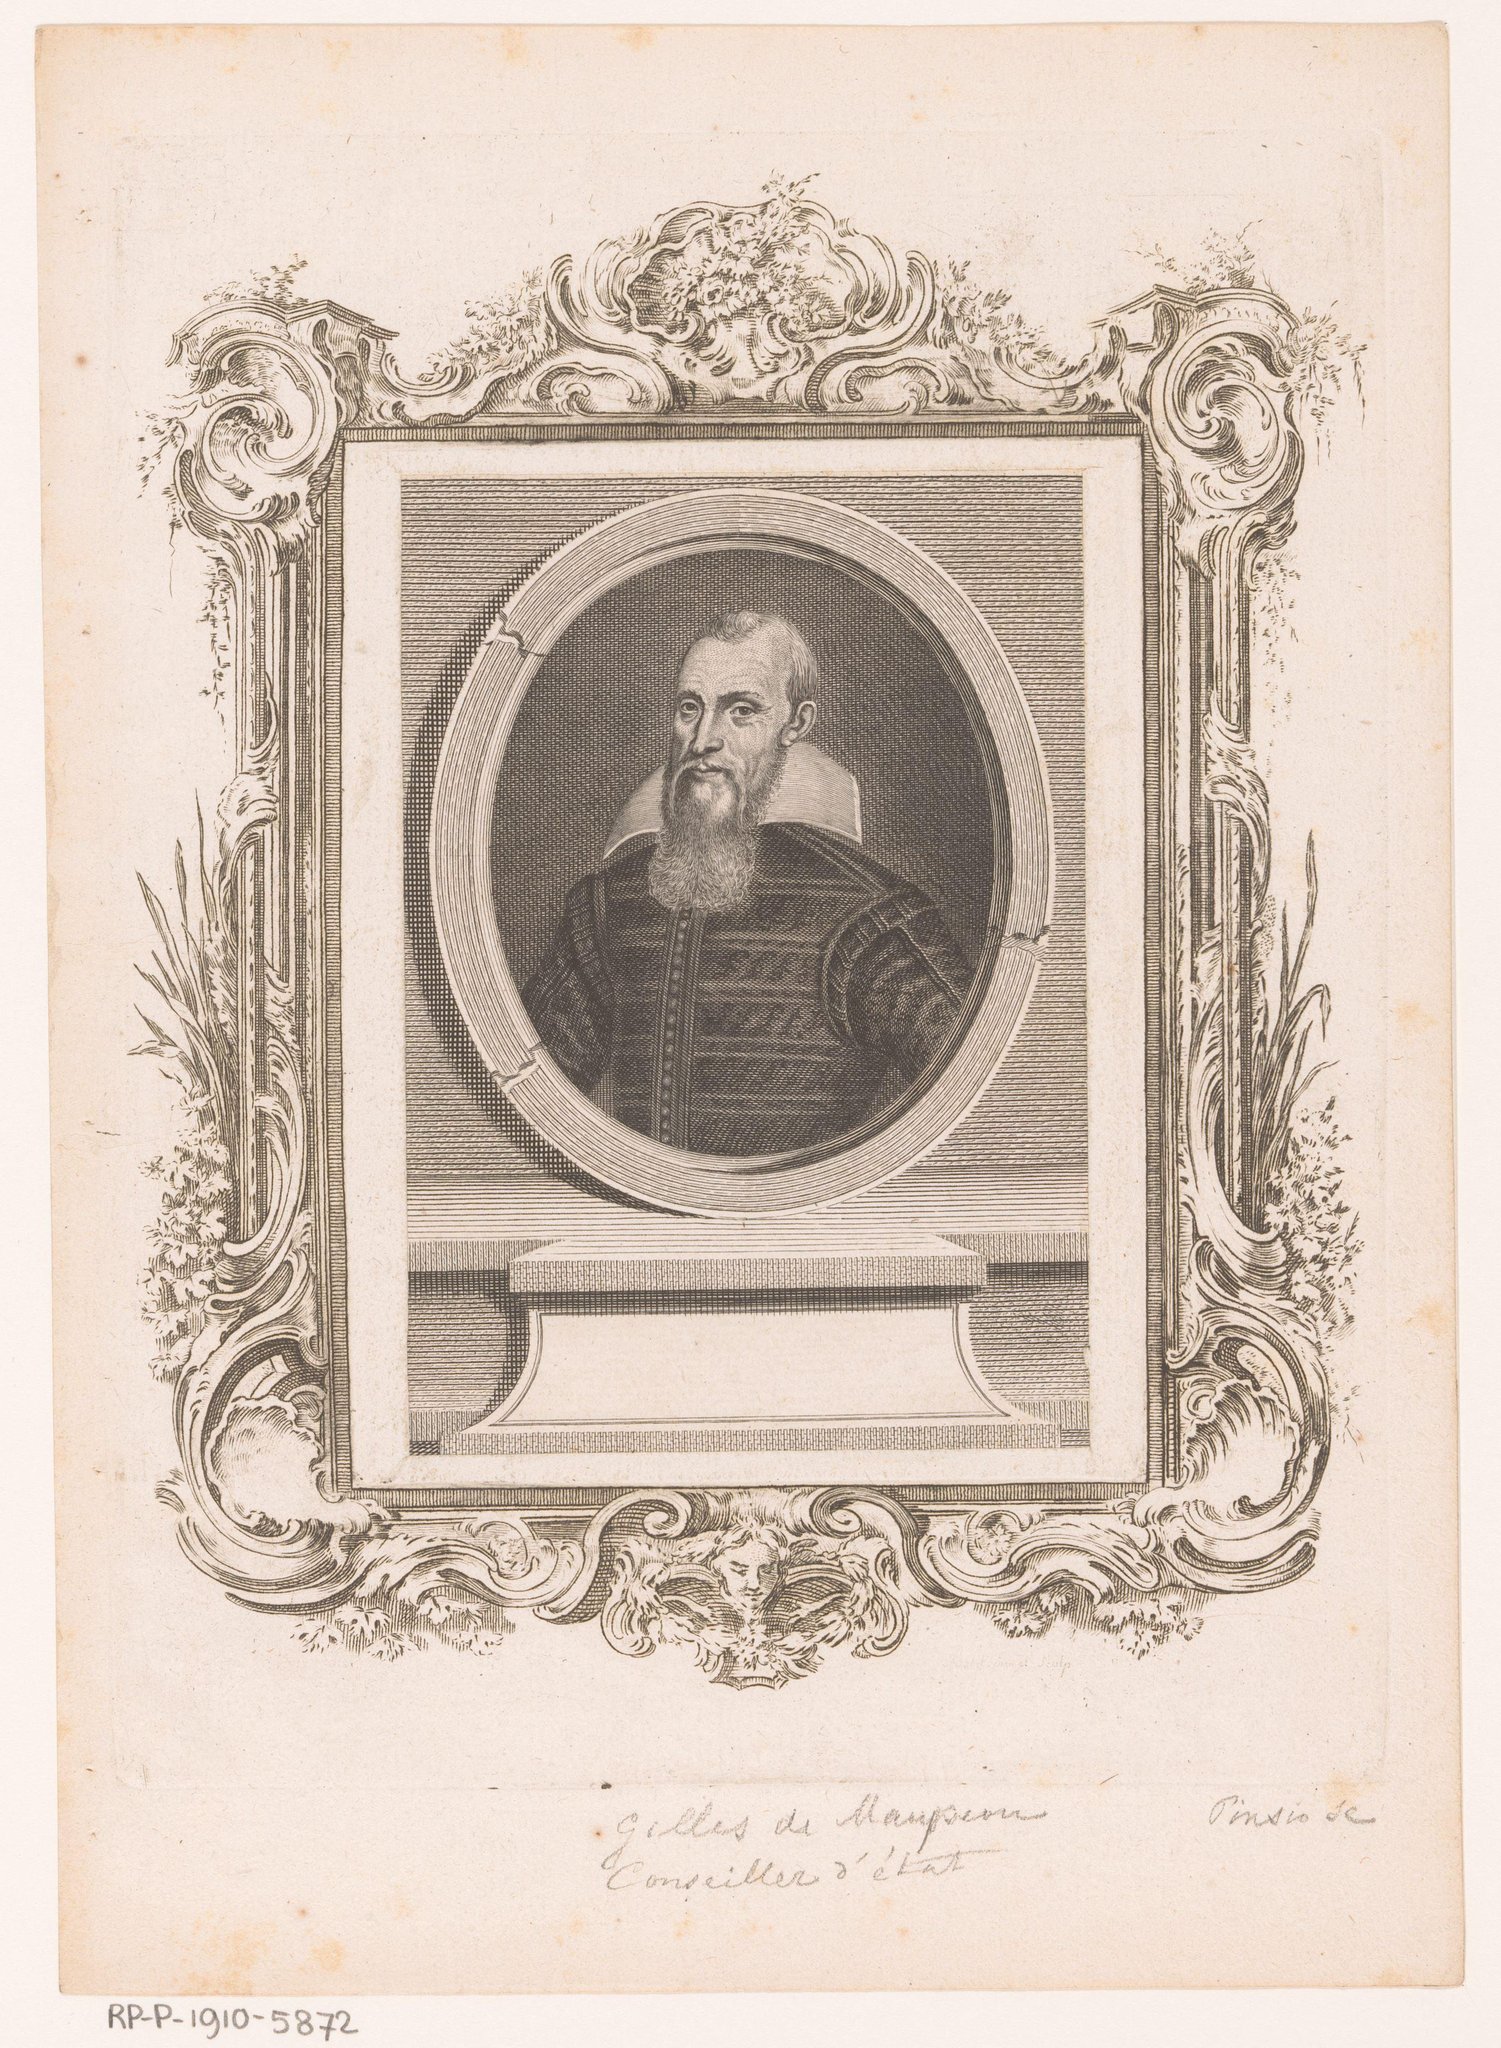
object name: book illustration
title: Louis VIII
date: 1755-1765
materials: paper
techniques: engraving, etching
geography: paris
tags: paris, historical persons, king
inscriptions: collector's mark: Lugt 2228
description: Prent uit: Dreux du Radier, Jean-François. L'Europe illustré, contenant l'histoire abregée des souverains, des princes, des prélats, des ministres, (...) en Europe: dans le XVe. siècle compris, jusqu'à présent. Parijs: Michel Odieuvre en André-François Le Breton, 1755-1765.